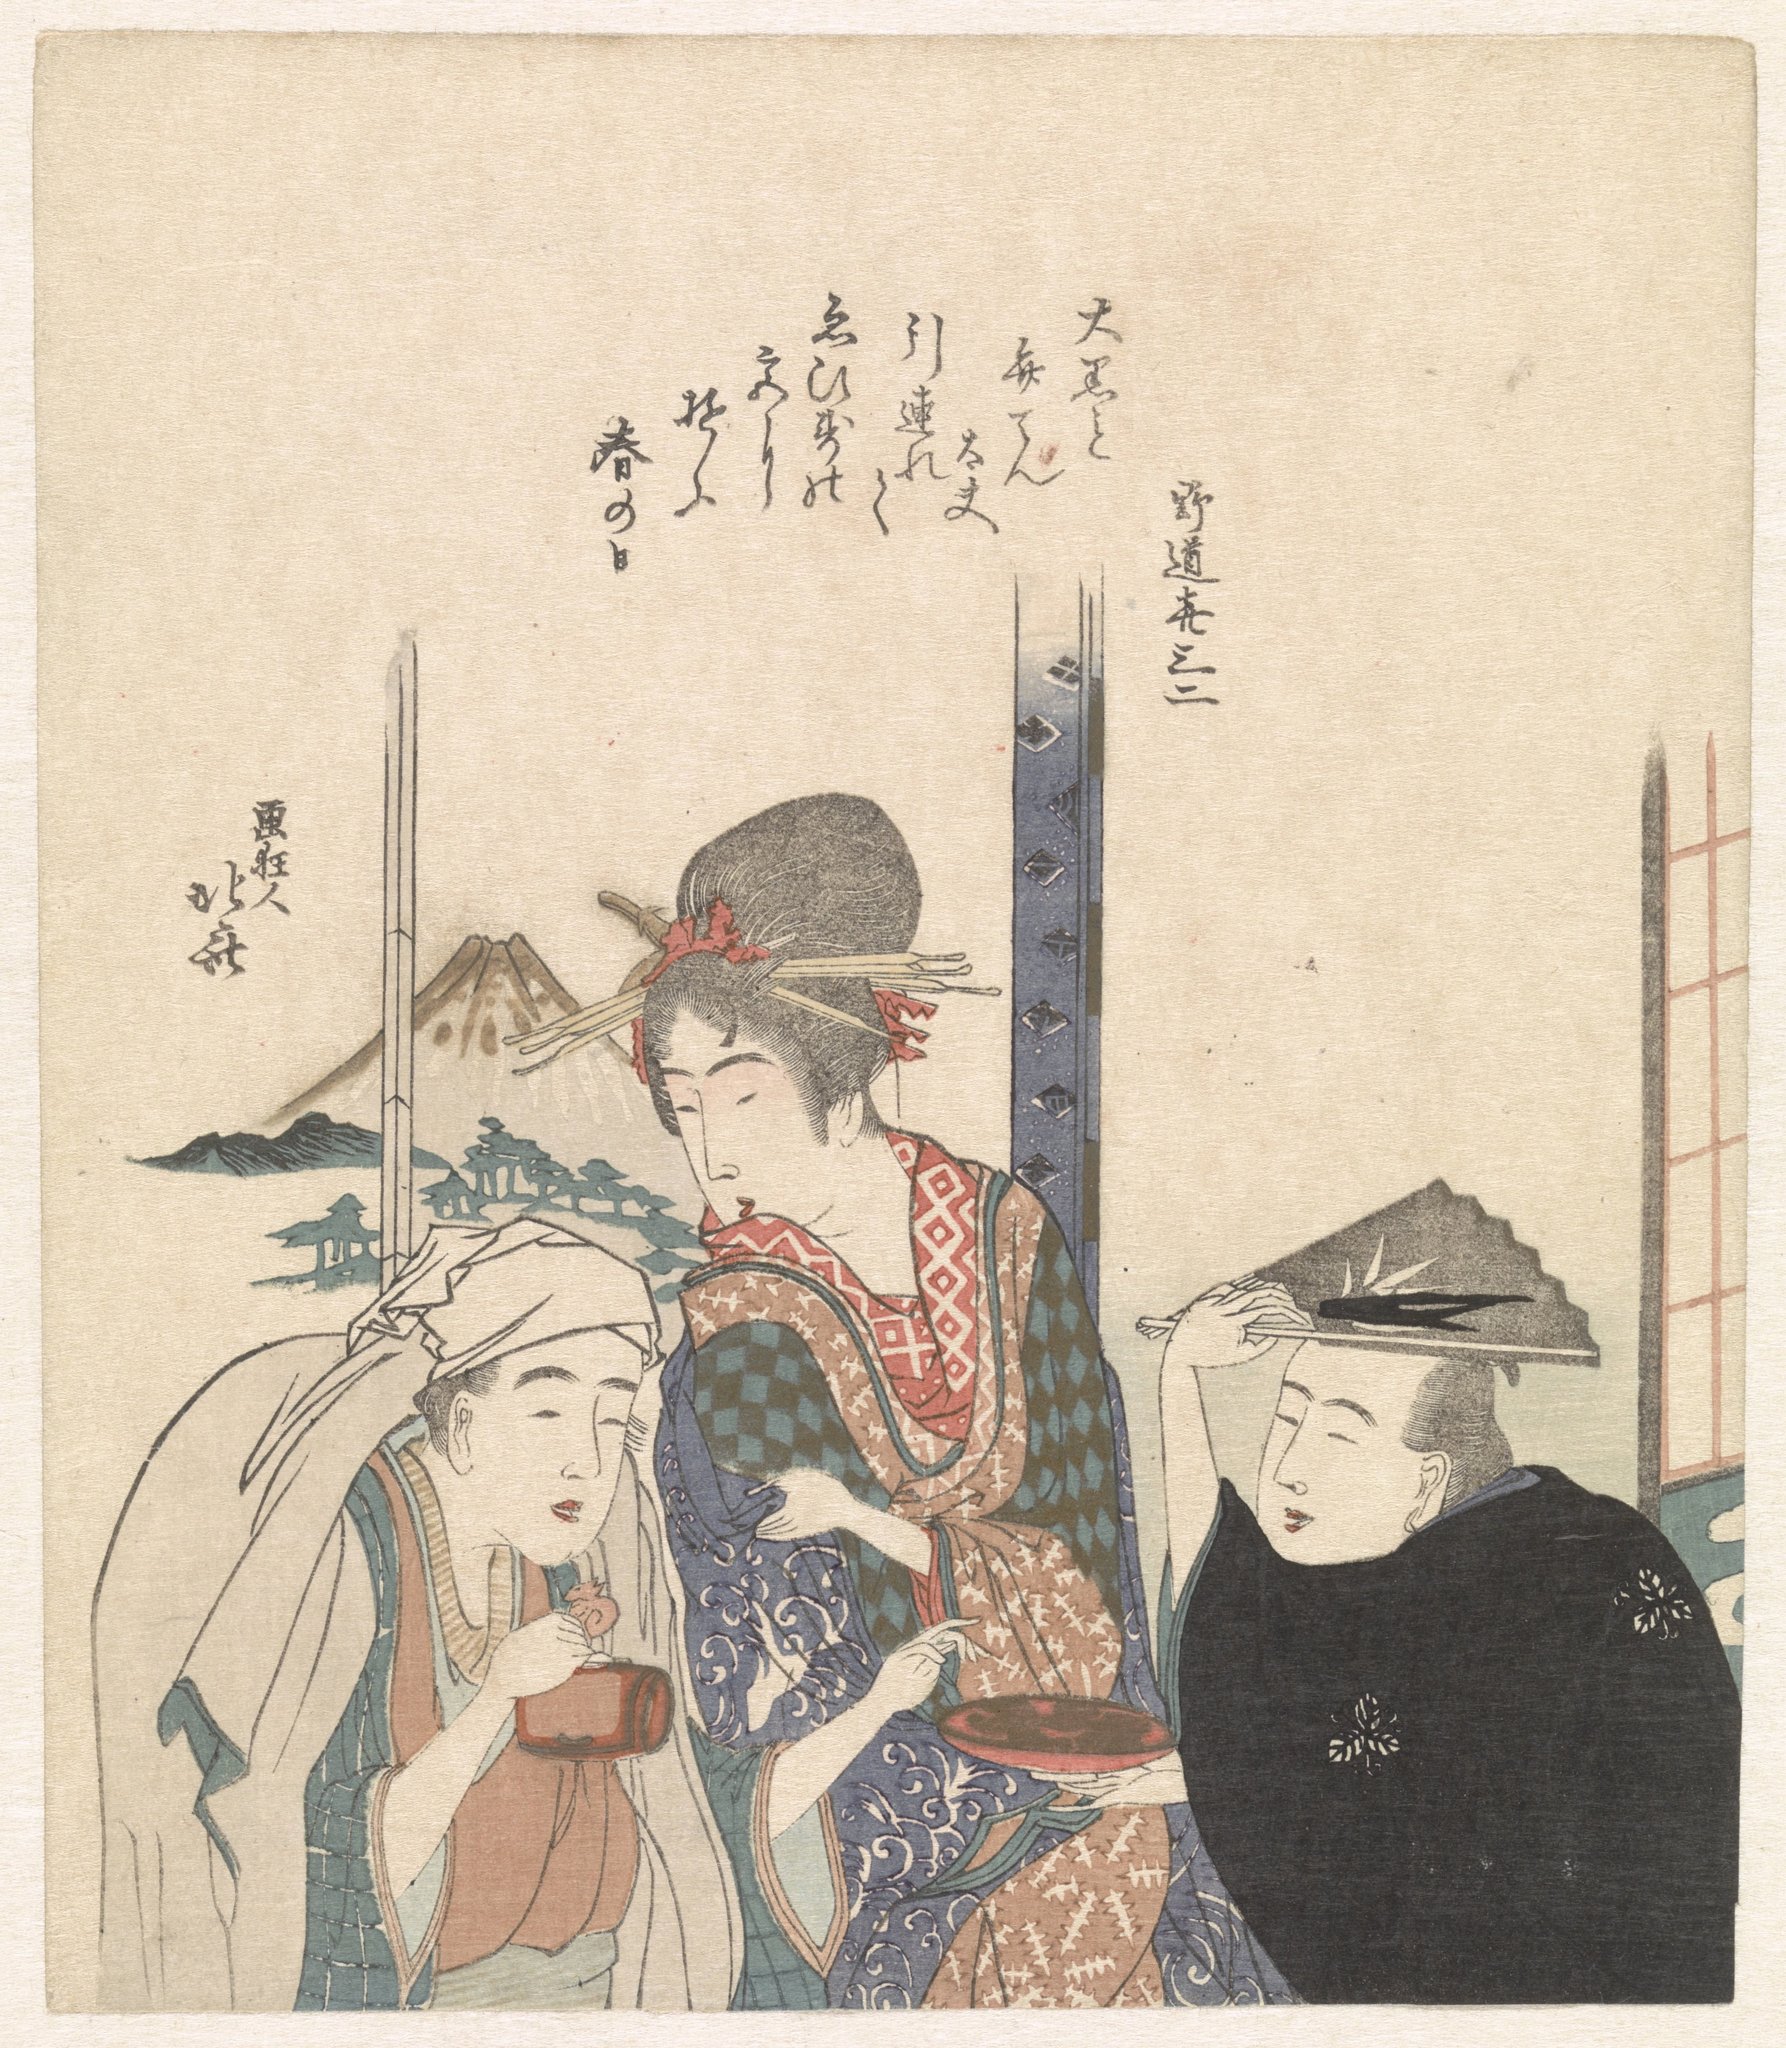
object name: print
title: Parodie van de goden Daikoku en Benten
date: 1890-1900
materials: paper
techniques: woodcut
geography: japan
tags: eating, mountains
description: Een surimono is een luxe uitgevoerde prent waarop beeld met één of meerdere gedichten gecombineerd is. Bij het drukken van een surimono werd vaak gebruik gemaakt van dikker papier, blinddruk en metaal pigmenten, zoals koper- en zilverpoeder. De prenten werden vaak in opdracht van dichters gemaakt en als exclusief geschenk aan vrienden en relaties gegeven.